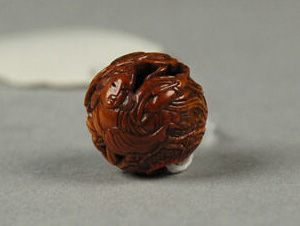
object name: ojime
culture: japanese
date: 1801-1900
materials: ivory